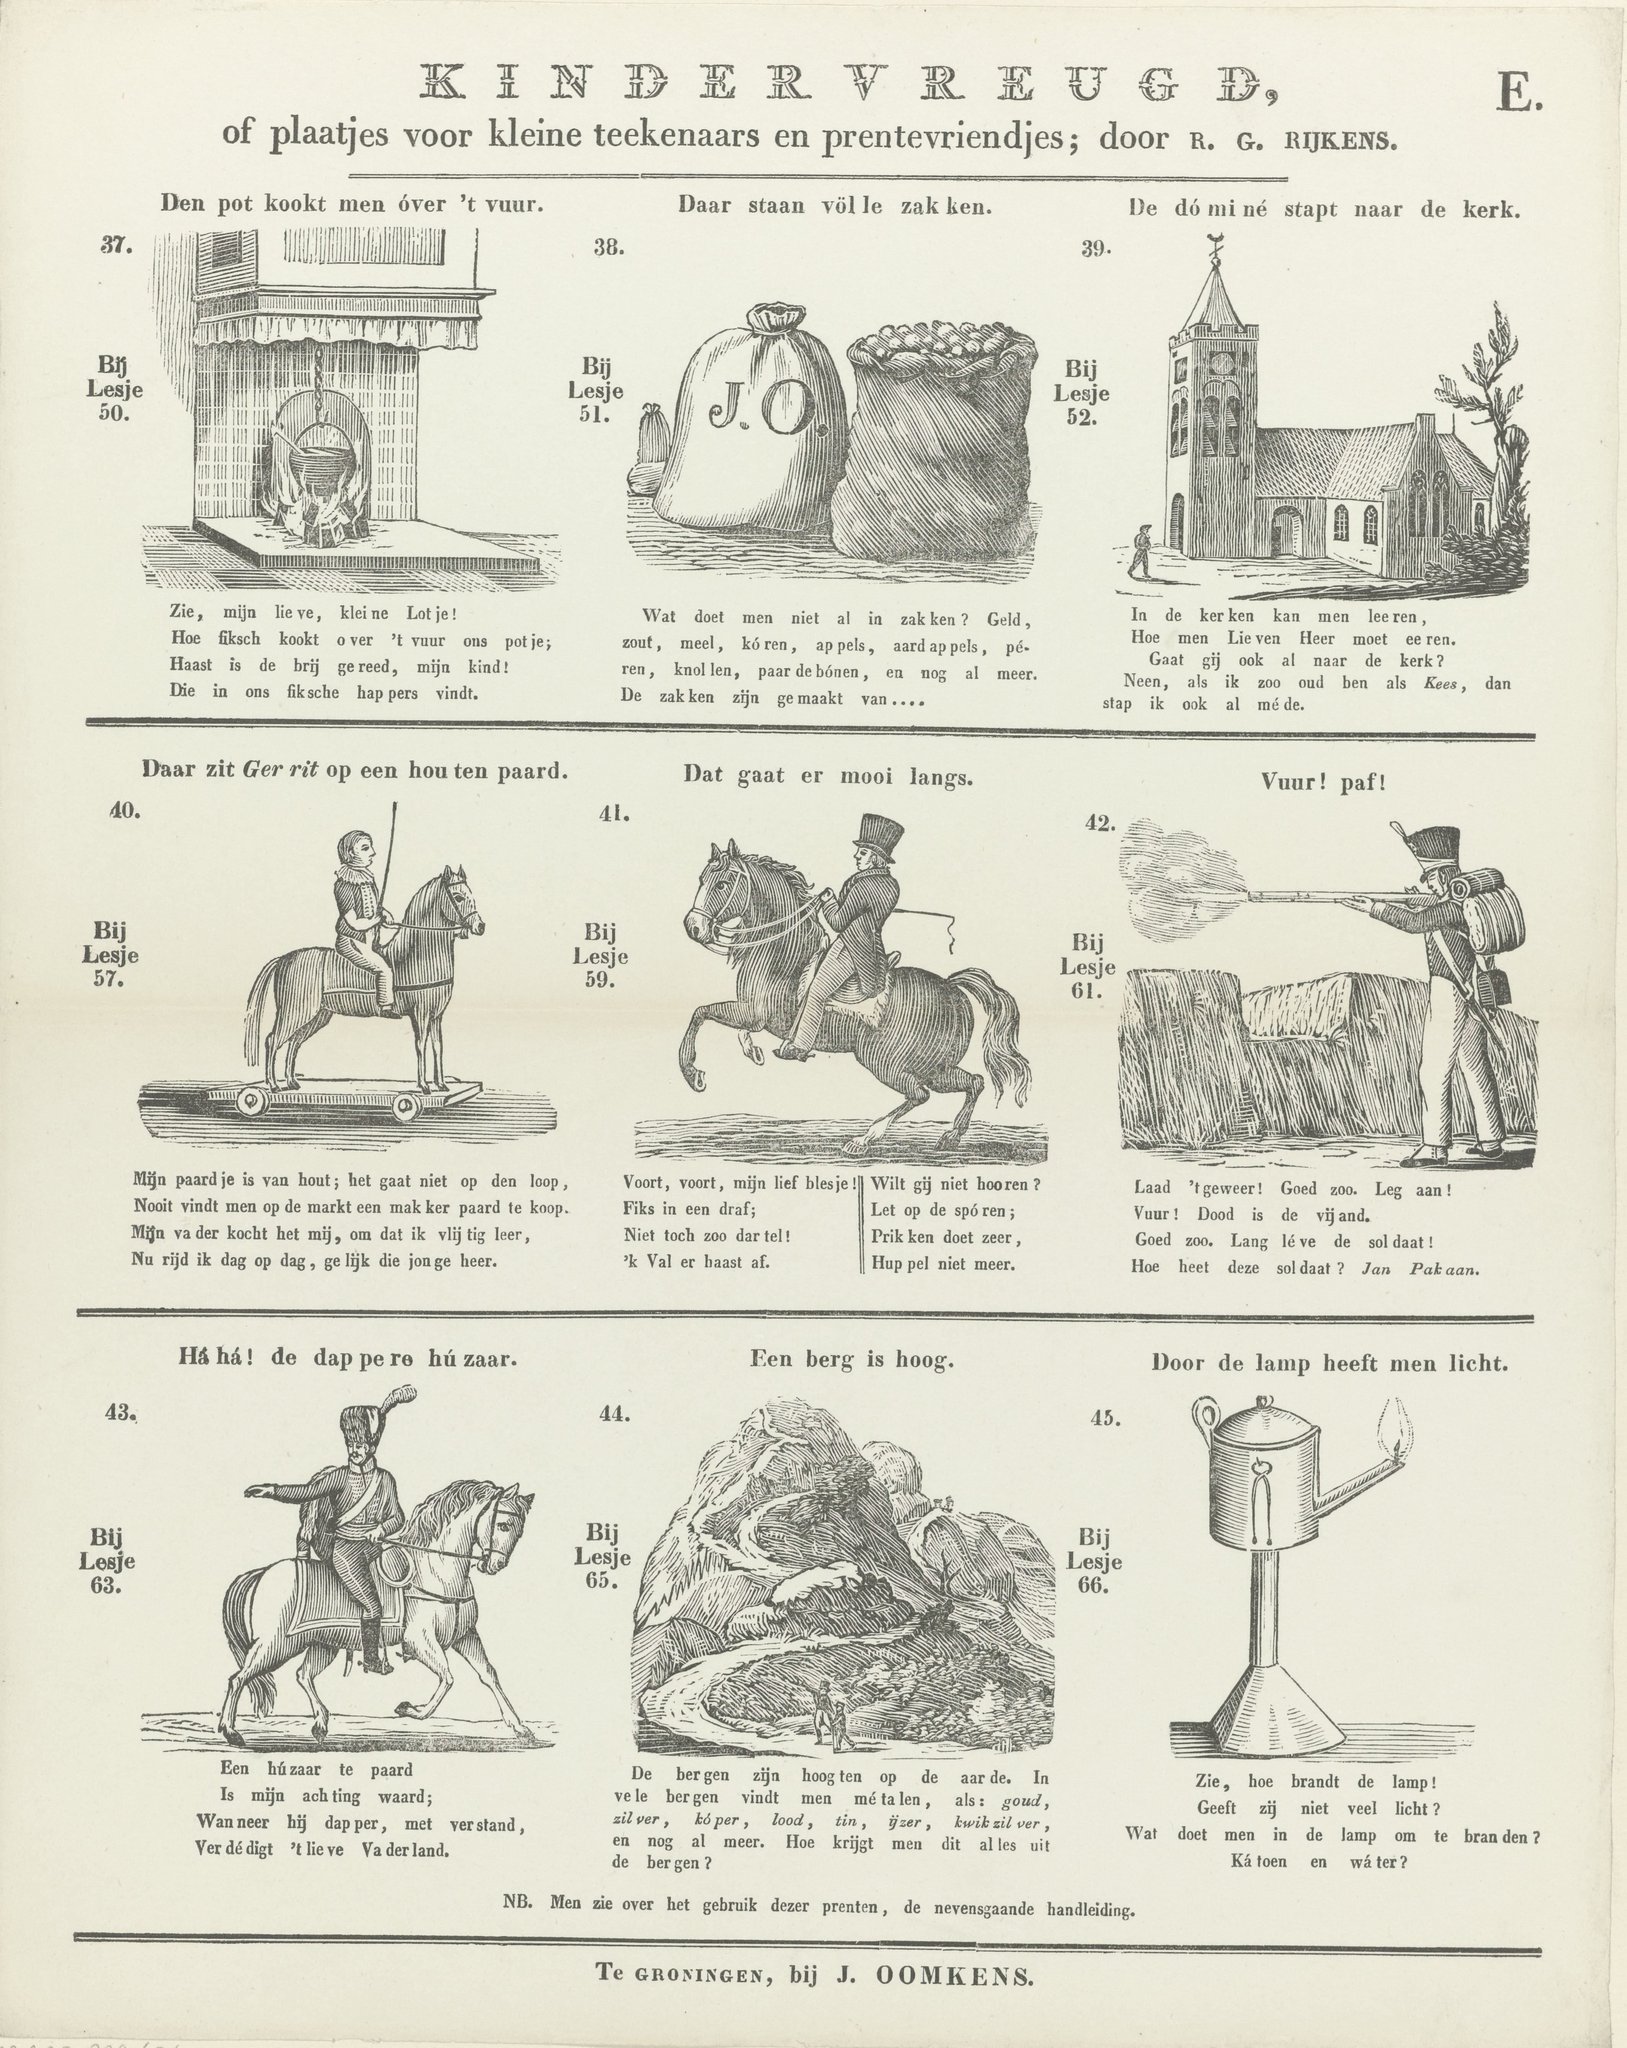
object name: print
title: Kindervreugd / of plaatjes voor kleine teekenaars en prentevriendjes; door R. G. Rijkens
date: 1808-1844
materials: paper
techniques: letterpress printing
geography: netherlands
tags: children's games and plays, church (exterior), kitchen-utensils: pot, education, mountains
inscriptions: collector's mark: Lugt 2760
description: Blad met 9 illustraties (genummerd 37-45) bij leesboekjes van R.G. Rijkens. Elk plaatje hoort bij een lesje uit de boekjes "Natuurlijke Lees-Leerwijze". Weergegeven zijn ondermeer een ketel op het vuur, zakken, een kerk, een jongen op een houten paard en een berg. Boven elke afbeelding een nummer en een titel en onder elke afbeelding een vierregelig vers. Links van elke afbeelding staat vermeld bij welke les het plaatje hoort. Gemerkt rechtsboven: E.